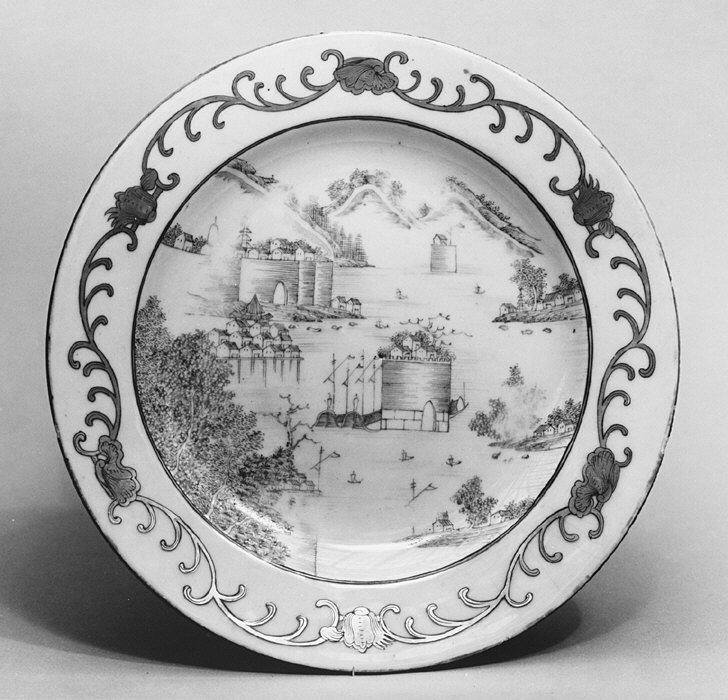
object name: plate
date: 1750-1760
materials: hard paste porcelain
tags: buildings,landscapes